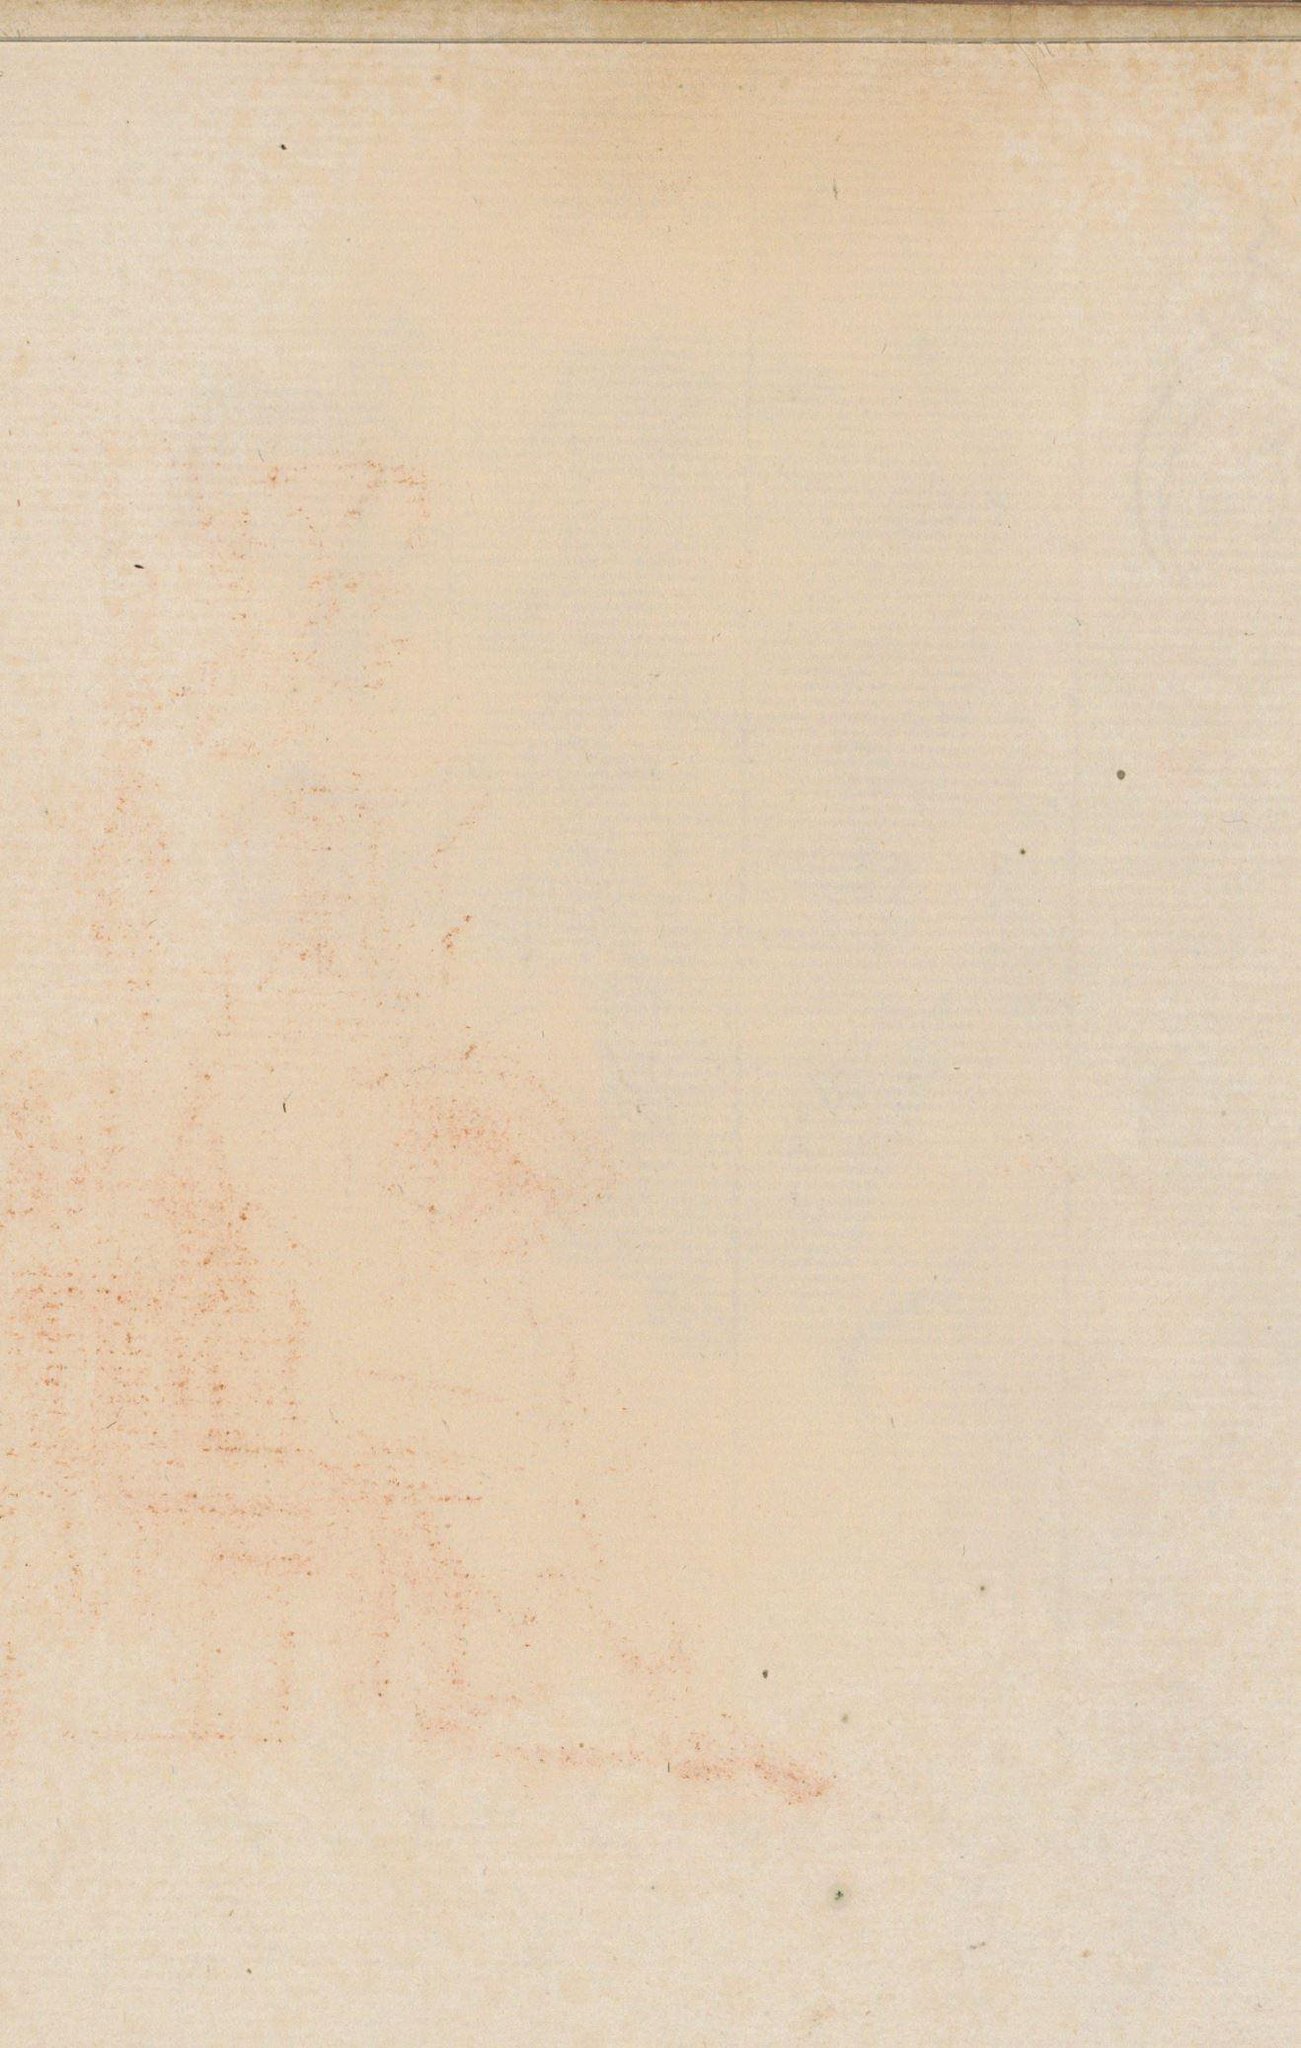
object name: sketchbook leaf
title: Abklatsch van een krijttekening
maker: jacob perkois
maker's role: draughtsman, print maker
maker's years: 1756-1804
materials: paper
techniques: printmaking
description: De tekening is niet langer aanwezig in het schetsboek. Bladzijde 24 uit een schetsboek met 78 bladzijden.